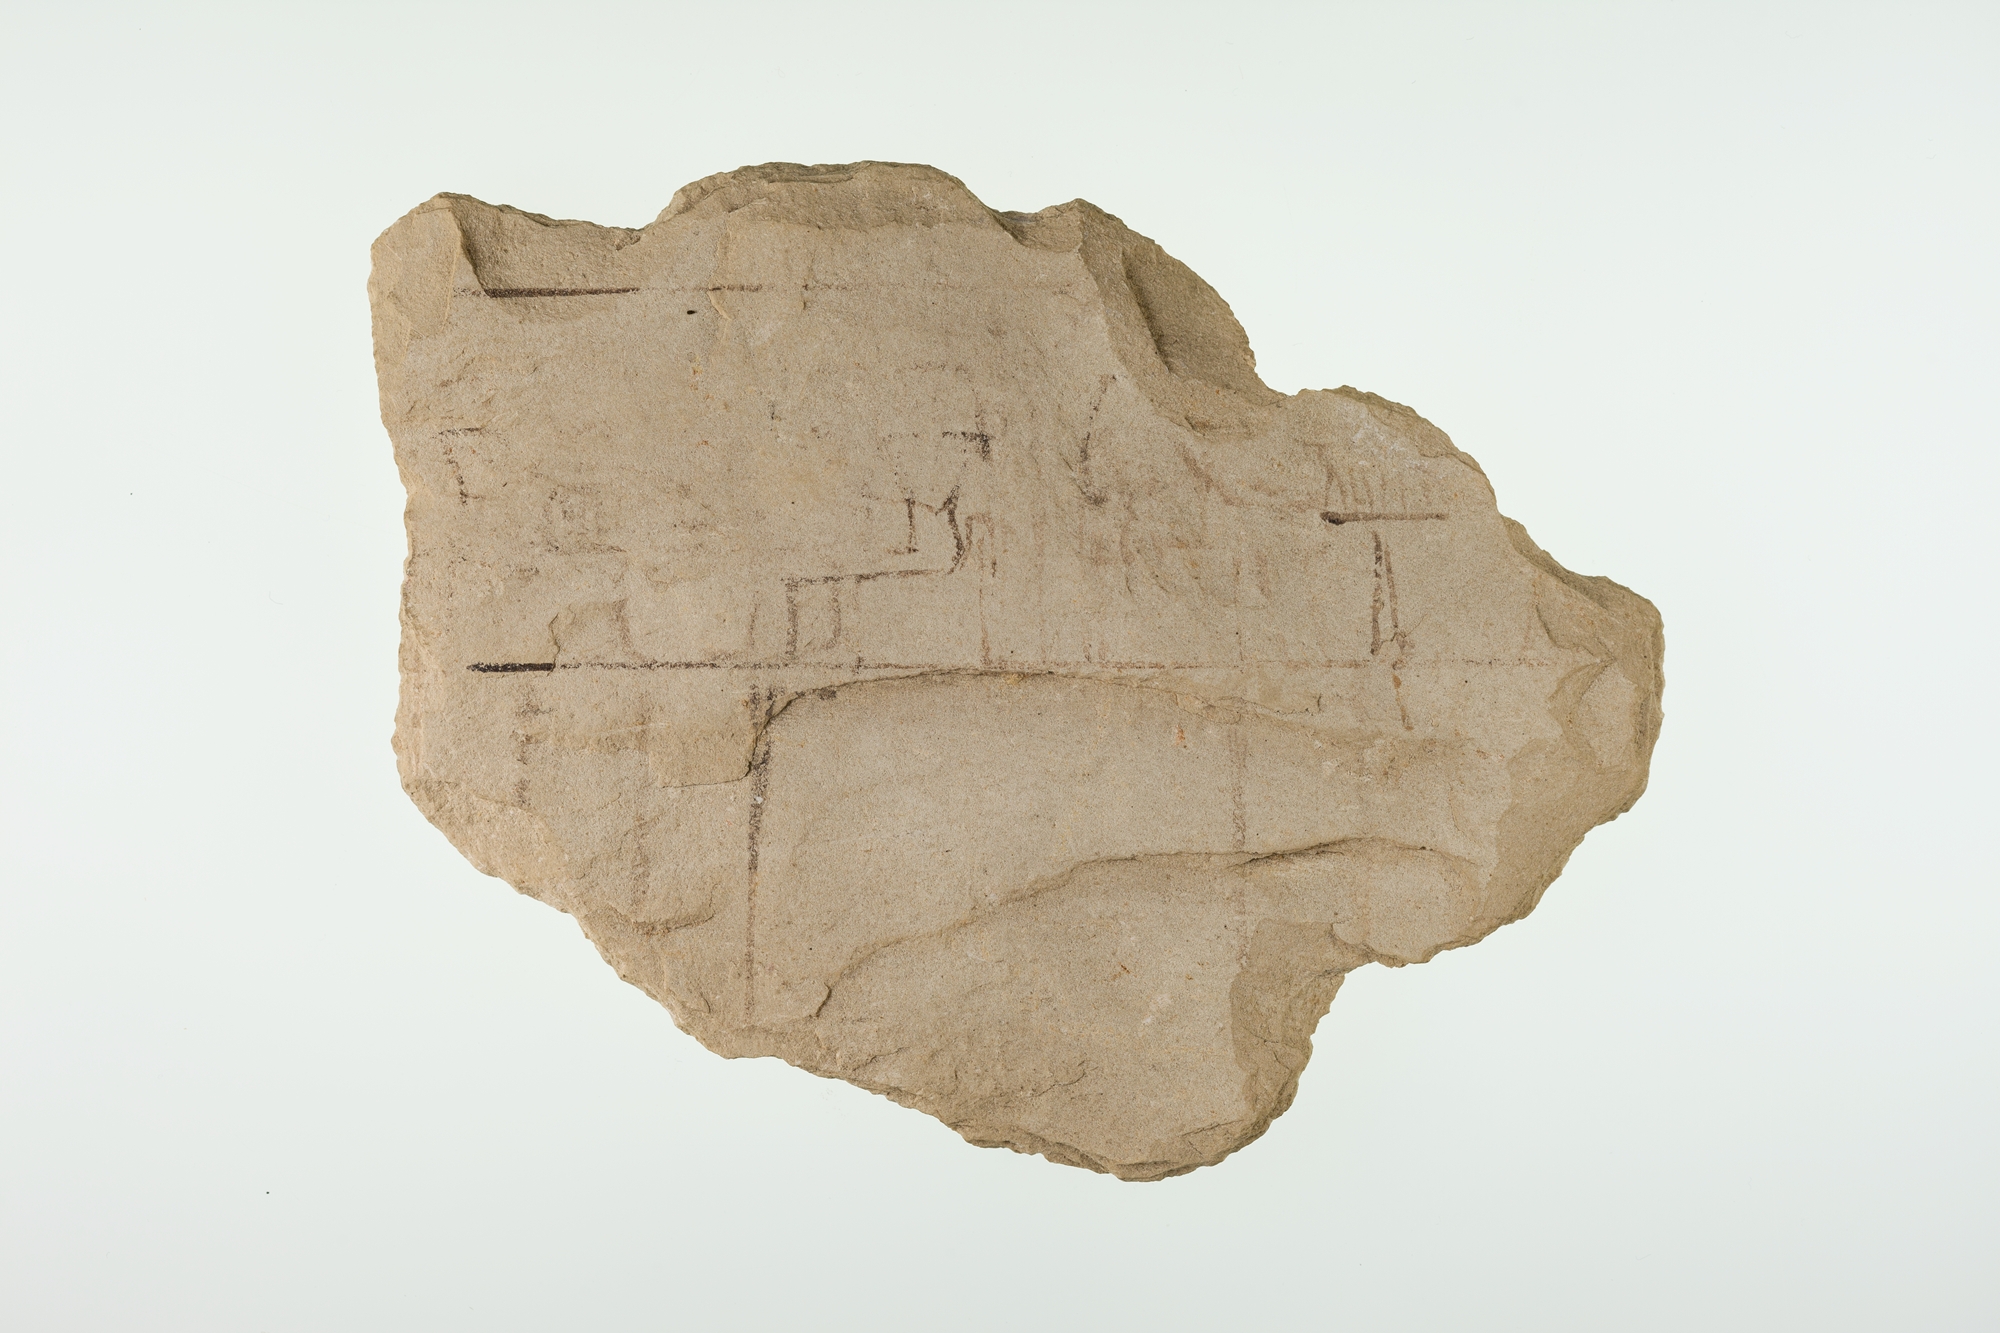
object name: ostracon, figured, senenmut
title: Ostracon With an Artist's Sketch of a Tomb Scene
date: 1479-1458 BCE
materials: ink, limestone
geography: egypt